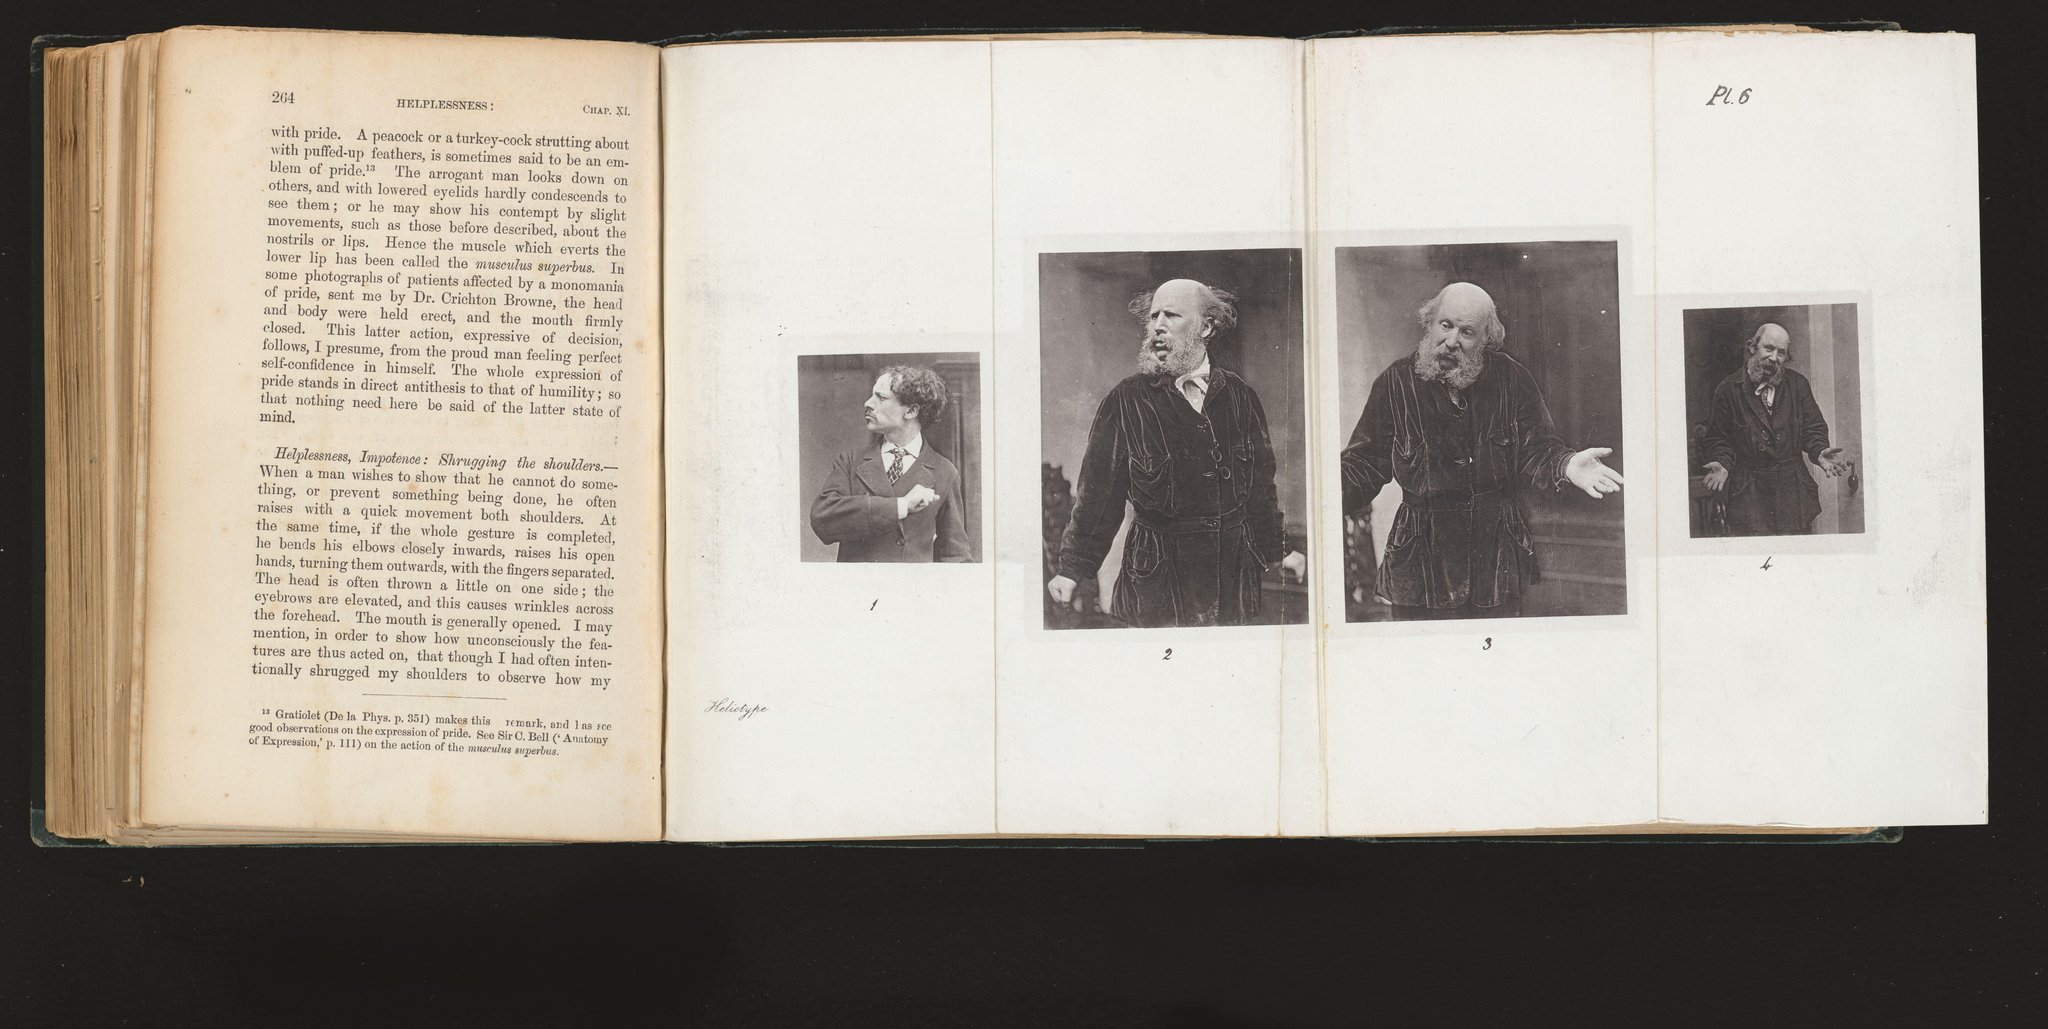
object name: page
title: Overzicht van vier foto's van mannen ter illustratie van verschil in lichaamstaal, waaronder drie zelfportretten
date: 1867-1872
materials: paper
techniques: photoaquatint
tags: oscar gustave rejlander, gesture-language, historical persons, morphology of facial expression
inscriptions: inscription: ‘Pl.6’